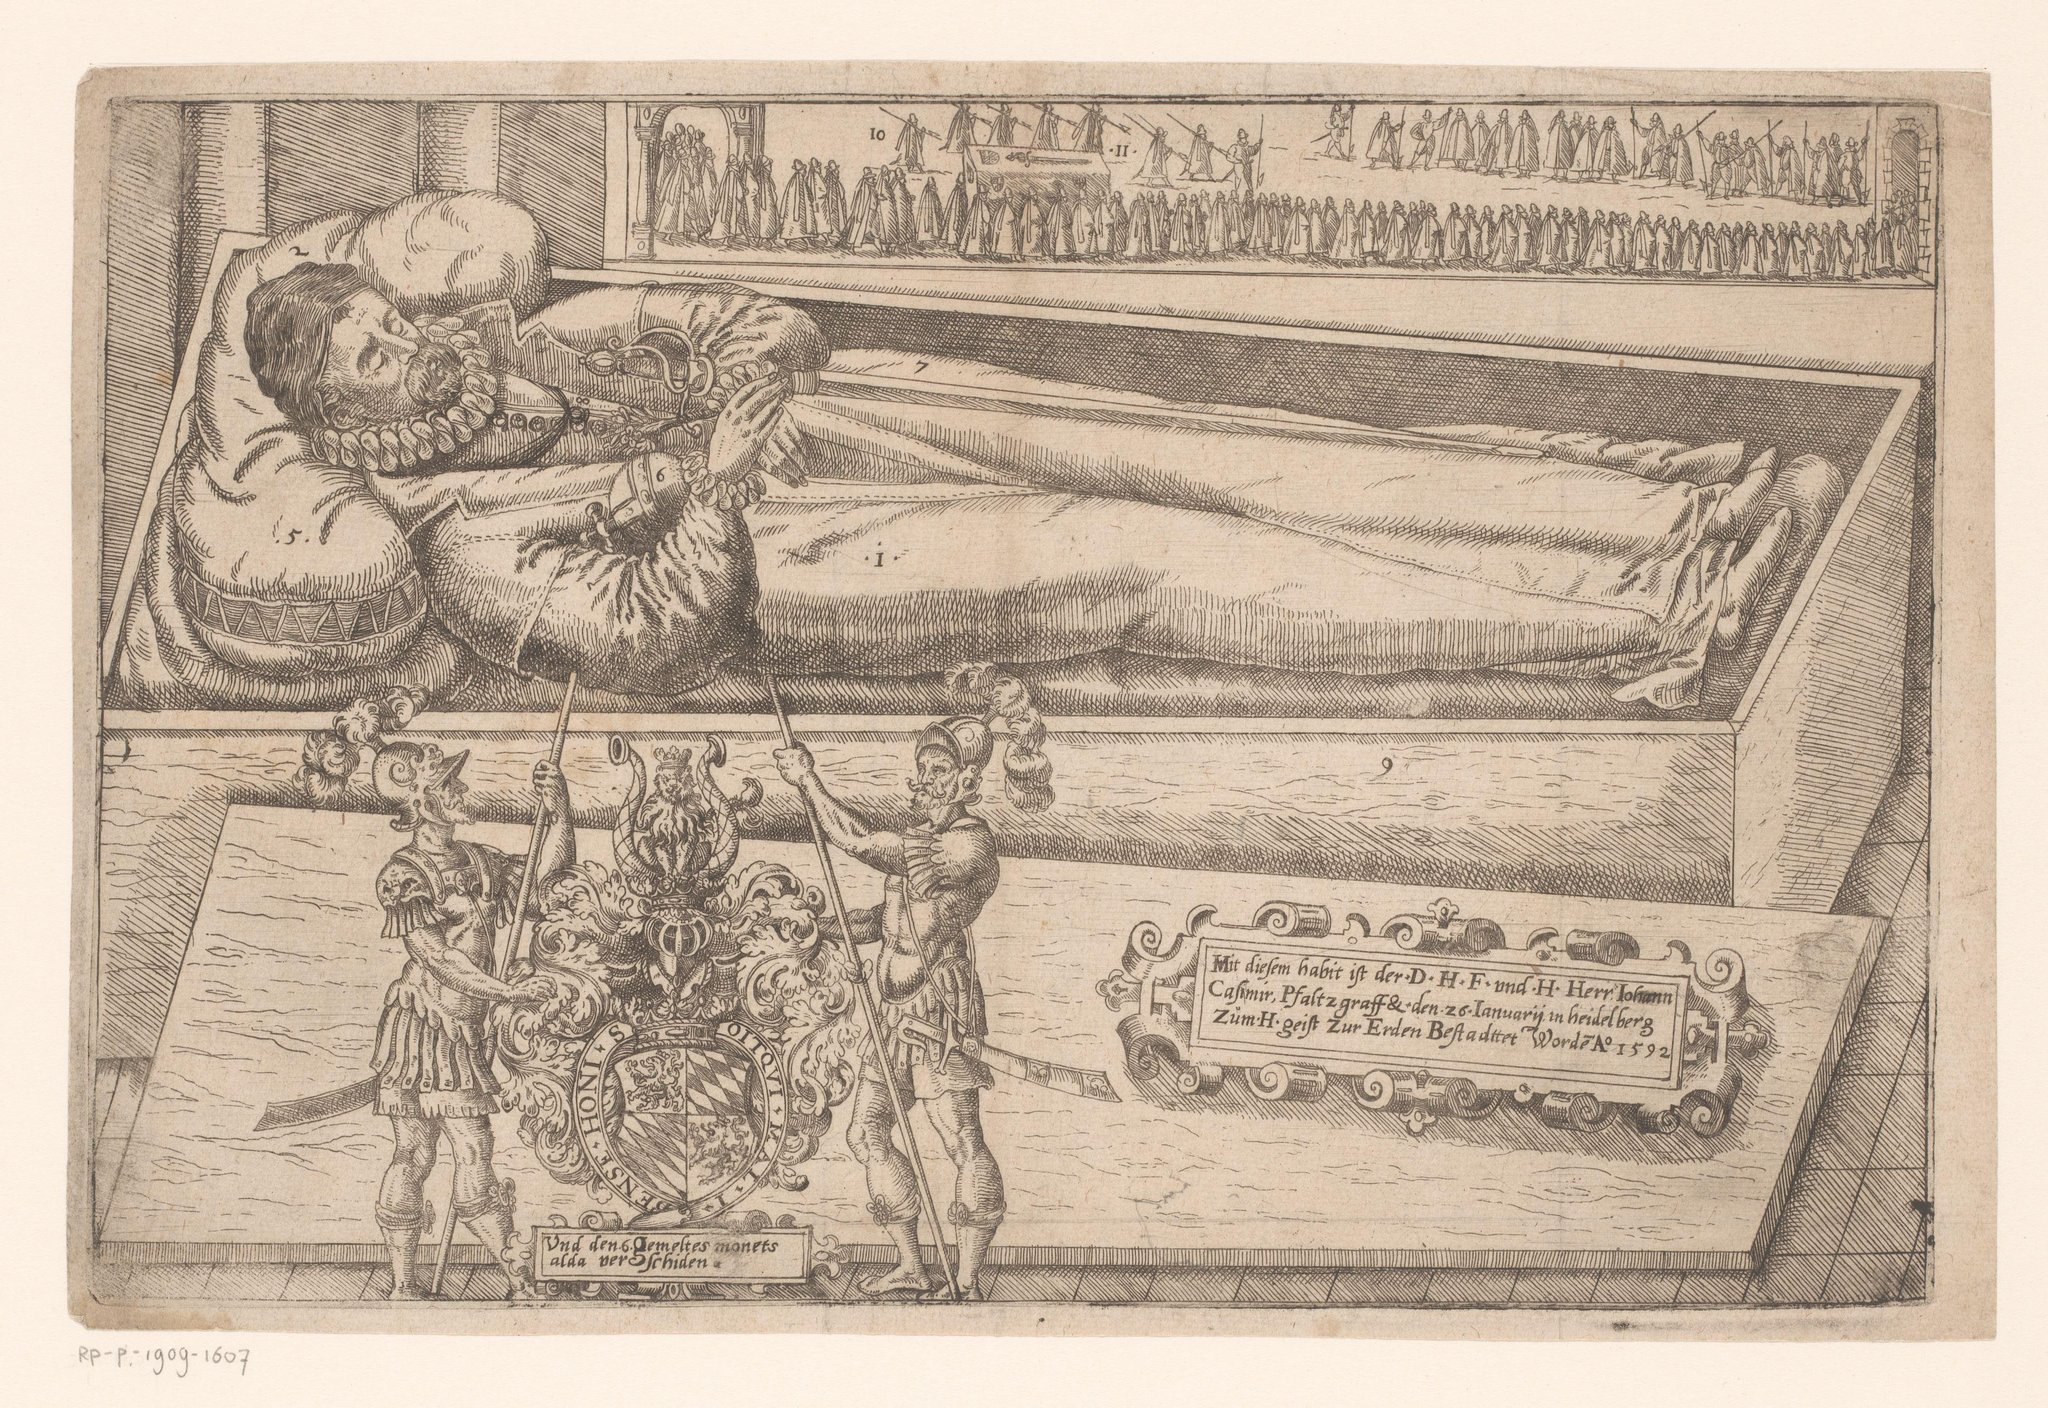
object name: print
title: Johan Casimir, paltsgraaf aan de Rijn, in zijn doodskist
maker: philipp uffenbach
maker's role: painter, print maker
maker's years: 1566-1636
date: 1592-1594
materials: paper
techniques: etching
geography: germany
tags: coffin, the corpse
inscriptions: collector's mark: Lugt 2228